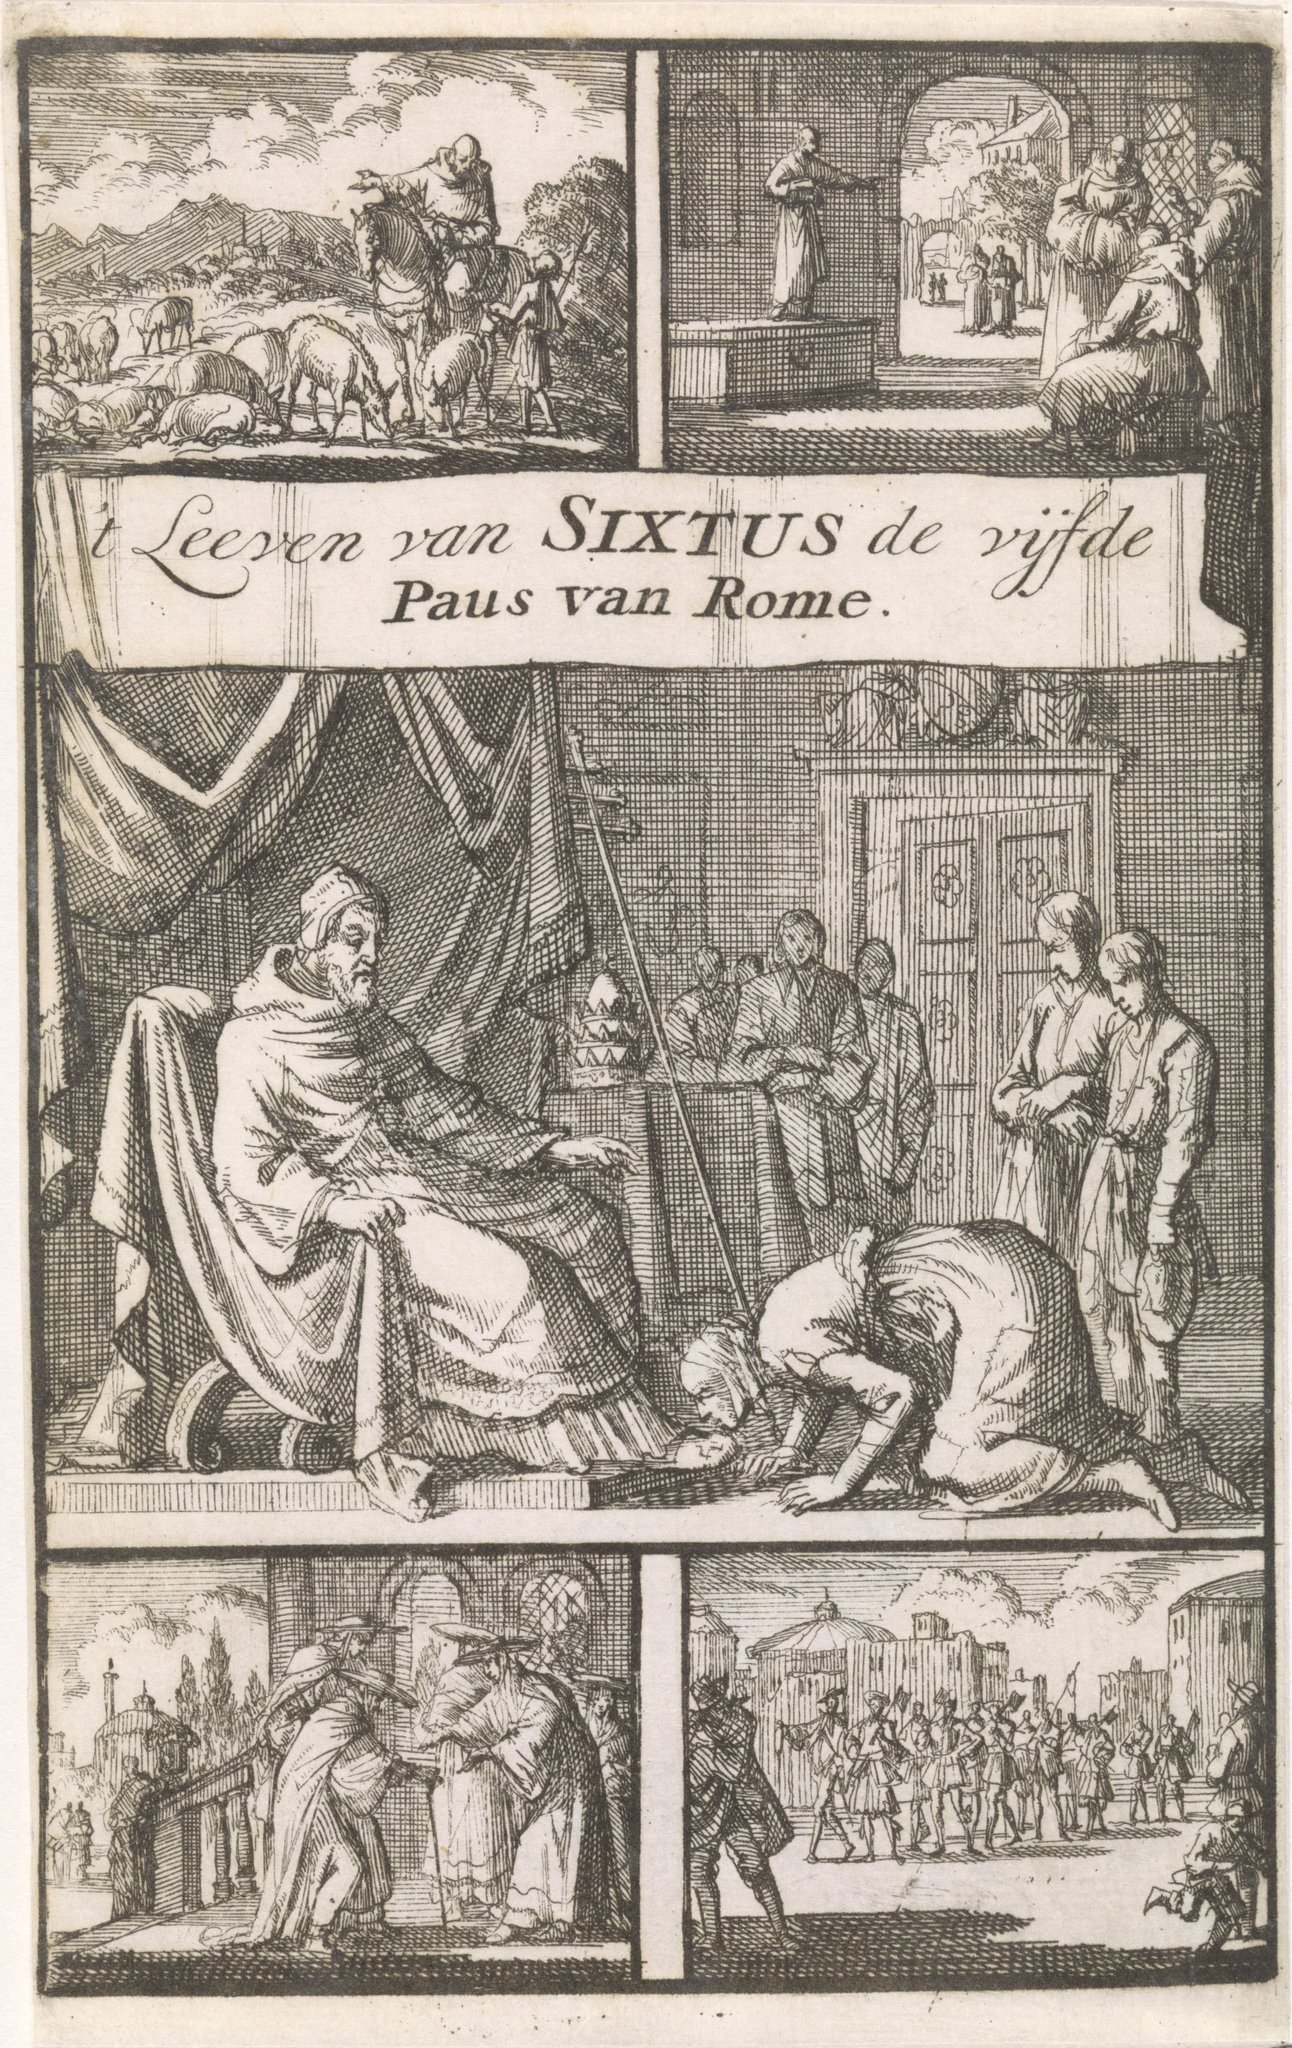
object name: print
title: Titelpagina voor: G. Leti, Het leeven van Sixtus den Vyfden, paus van Rome,1697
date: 1697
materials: paper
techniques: etching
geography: amsterdam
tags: rome, sixtus v, kissing the pope's feet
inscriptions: collector's mark: Lugt 2228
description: Camilla, de zuster van paus Sixtus V, kust geknield zijn voet. Hierachter kijken figuren toe. Boven en onder deze centrale afbeeldingen vier scènes uit het leven van paus Sixtus V.